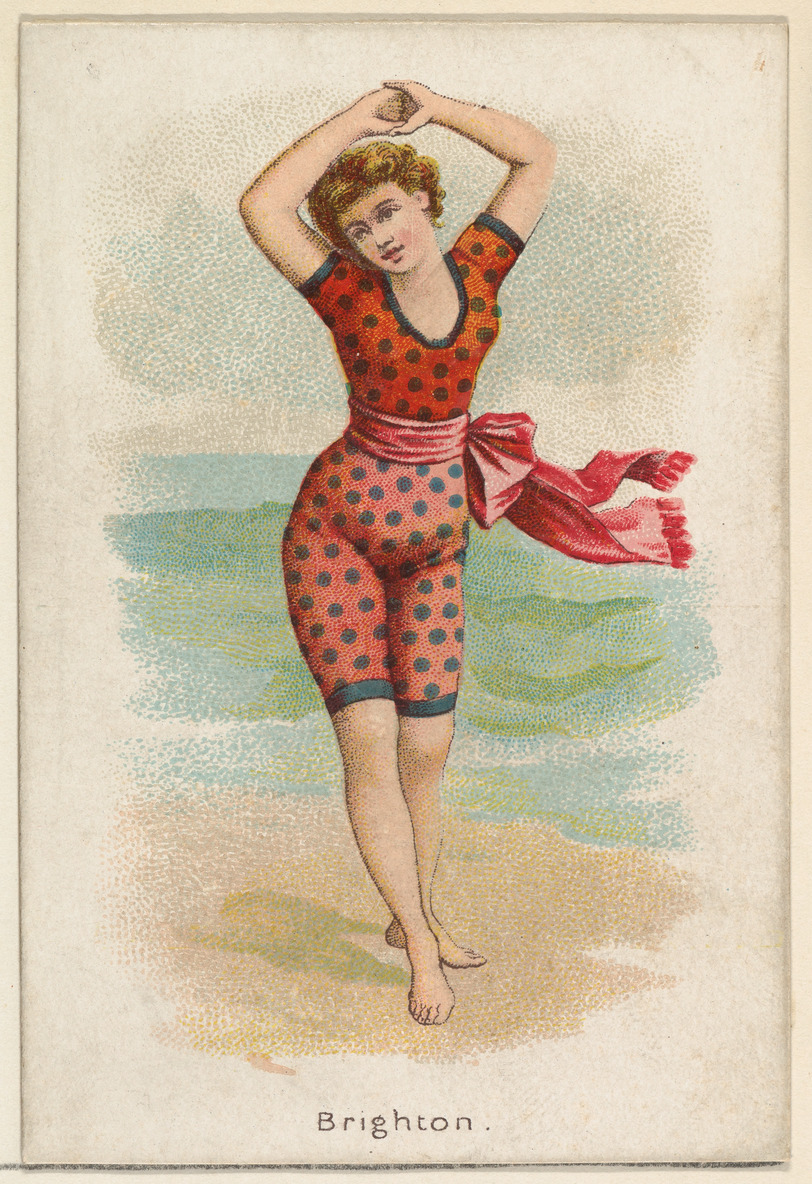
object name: print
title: Brighton, from the Beautiful Bathers series (N192) issued by Wm. S. Kimball & Co.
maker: william s. kimball & company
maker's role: publisher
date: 1889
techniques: color lithograph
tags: women